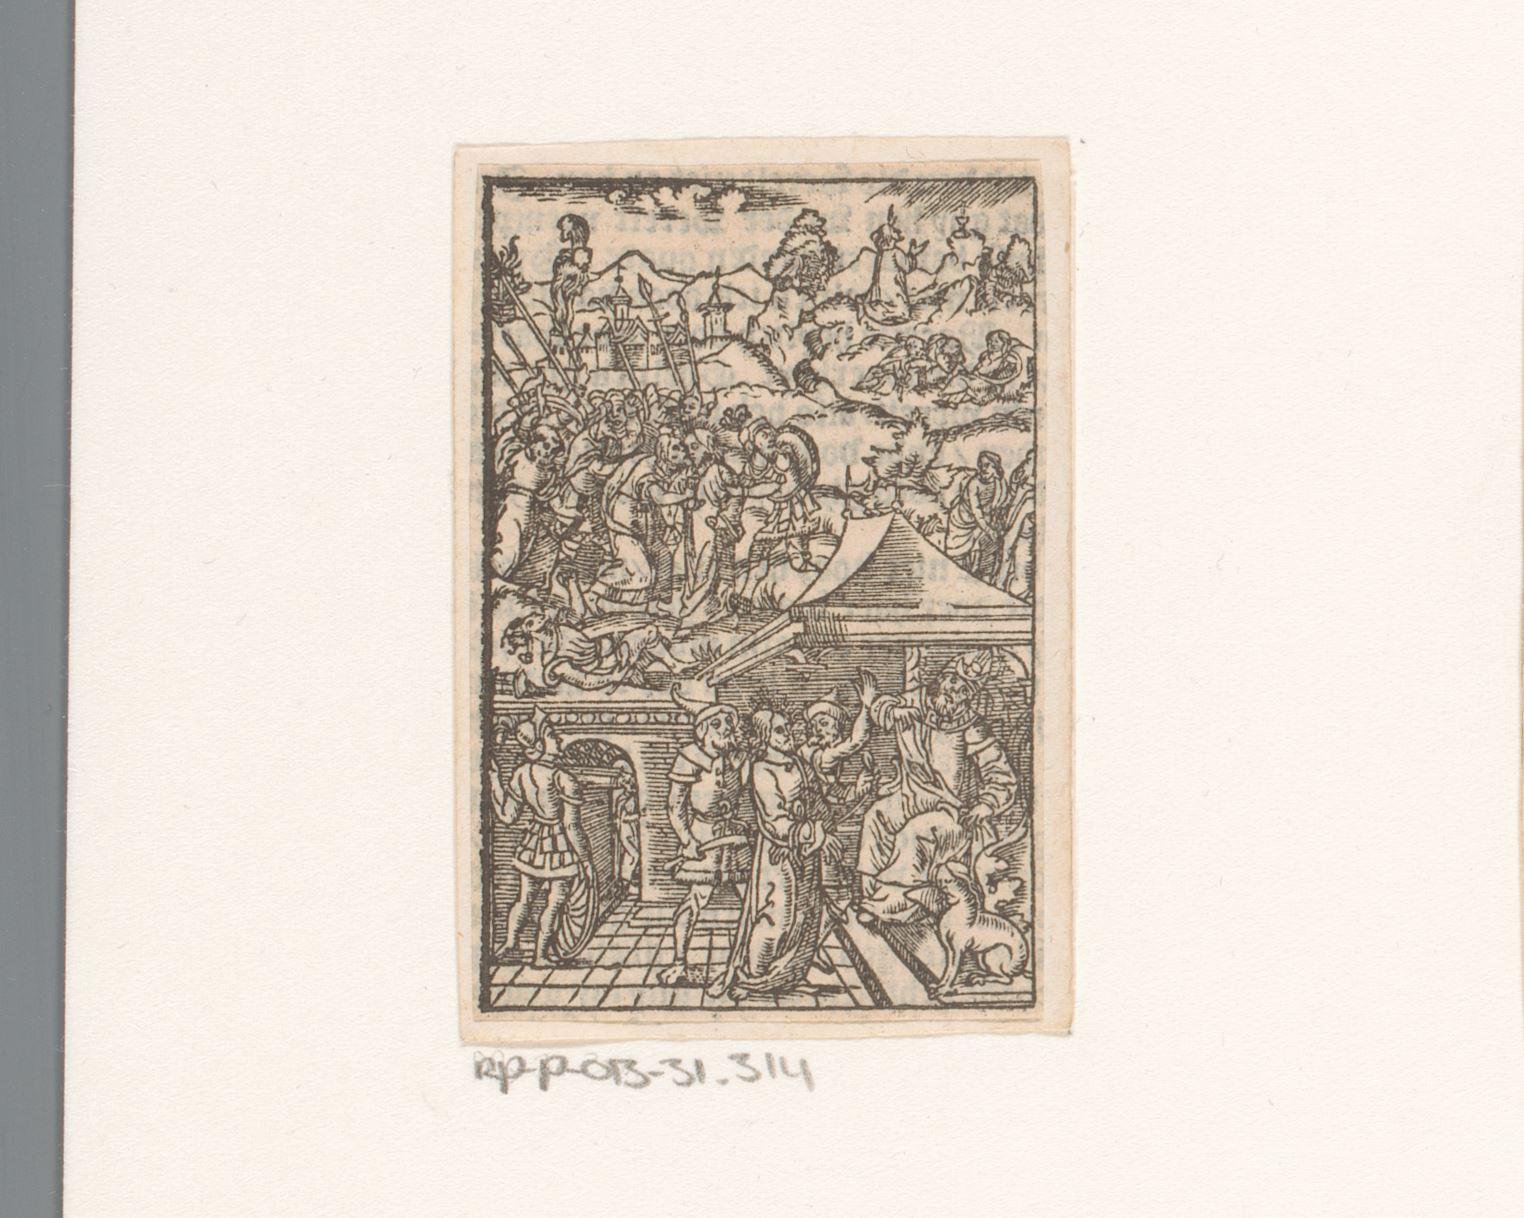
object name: book illustration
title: Christus voor Annas en in de hof van Getsemane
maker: Anonymous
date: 1600-1699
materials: paper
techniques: letterpress printing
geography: netherlands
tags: agony of christ; three (or eleven) apostles sleeping, christ before annas (hanna); maybe a soldier about to strike christ (john 18:13, 18:19-24)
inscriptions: collector's mark: Lugt 240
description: Christus wordt door gewapende soldaten voor de hogepriester Annas geleid. Eén van de soldaten staat op het punt Christus in het gezicht te slaan. Op de achtergrond bidt Christus in de hof van Getsemane en vraagt aan God of deze beker aan hem voorbij mag gaan. Petrus, Johannes en Jacobus slapen.